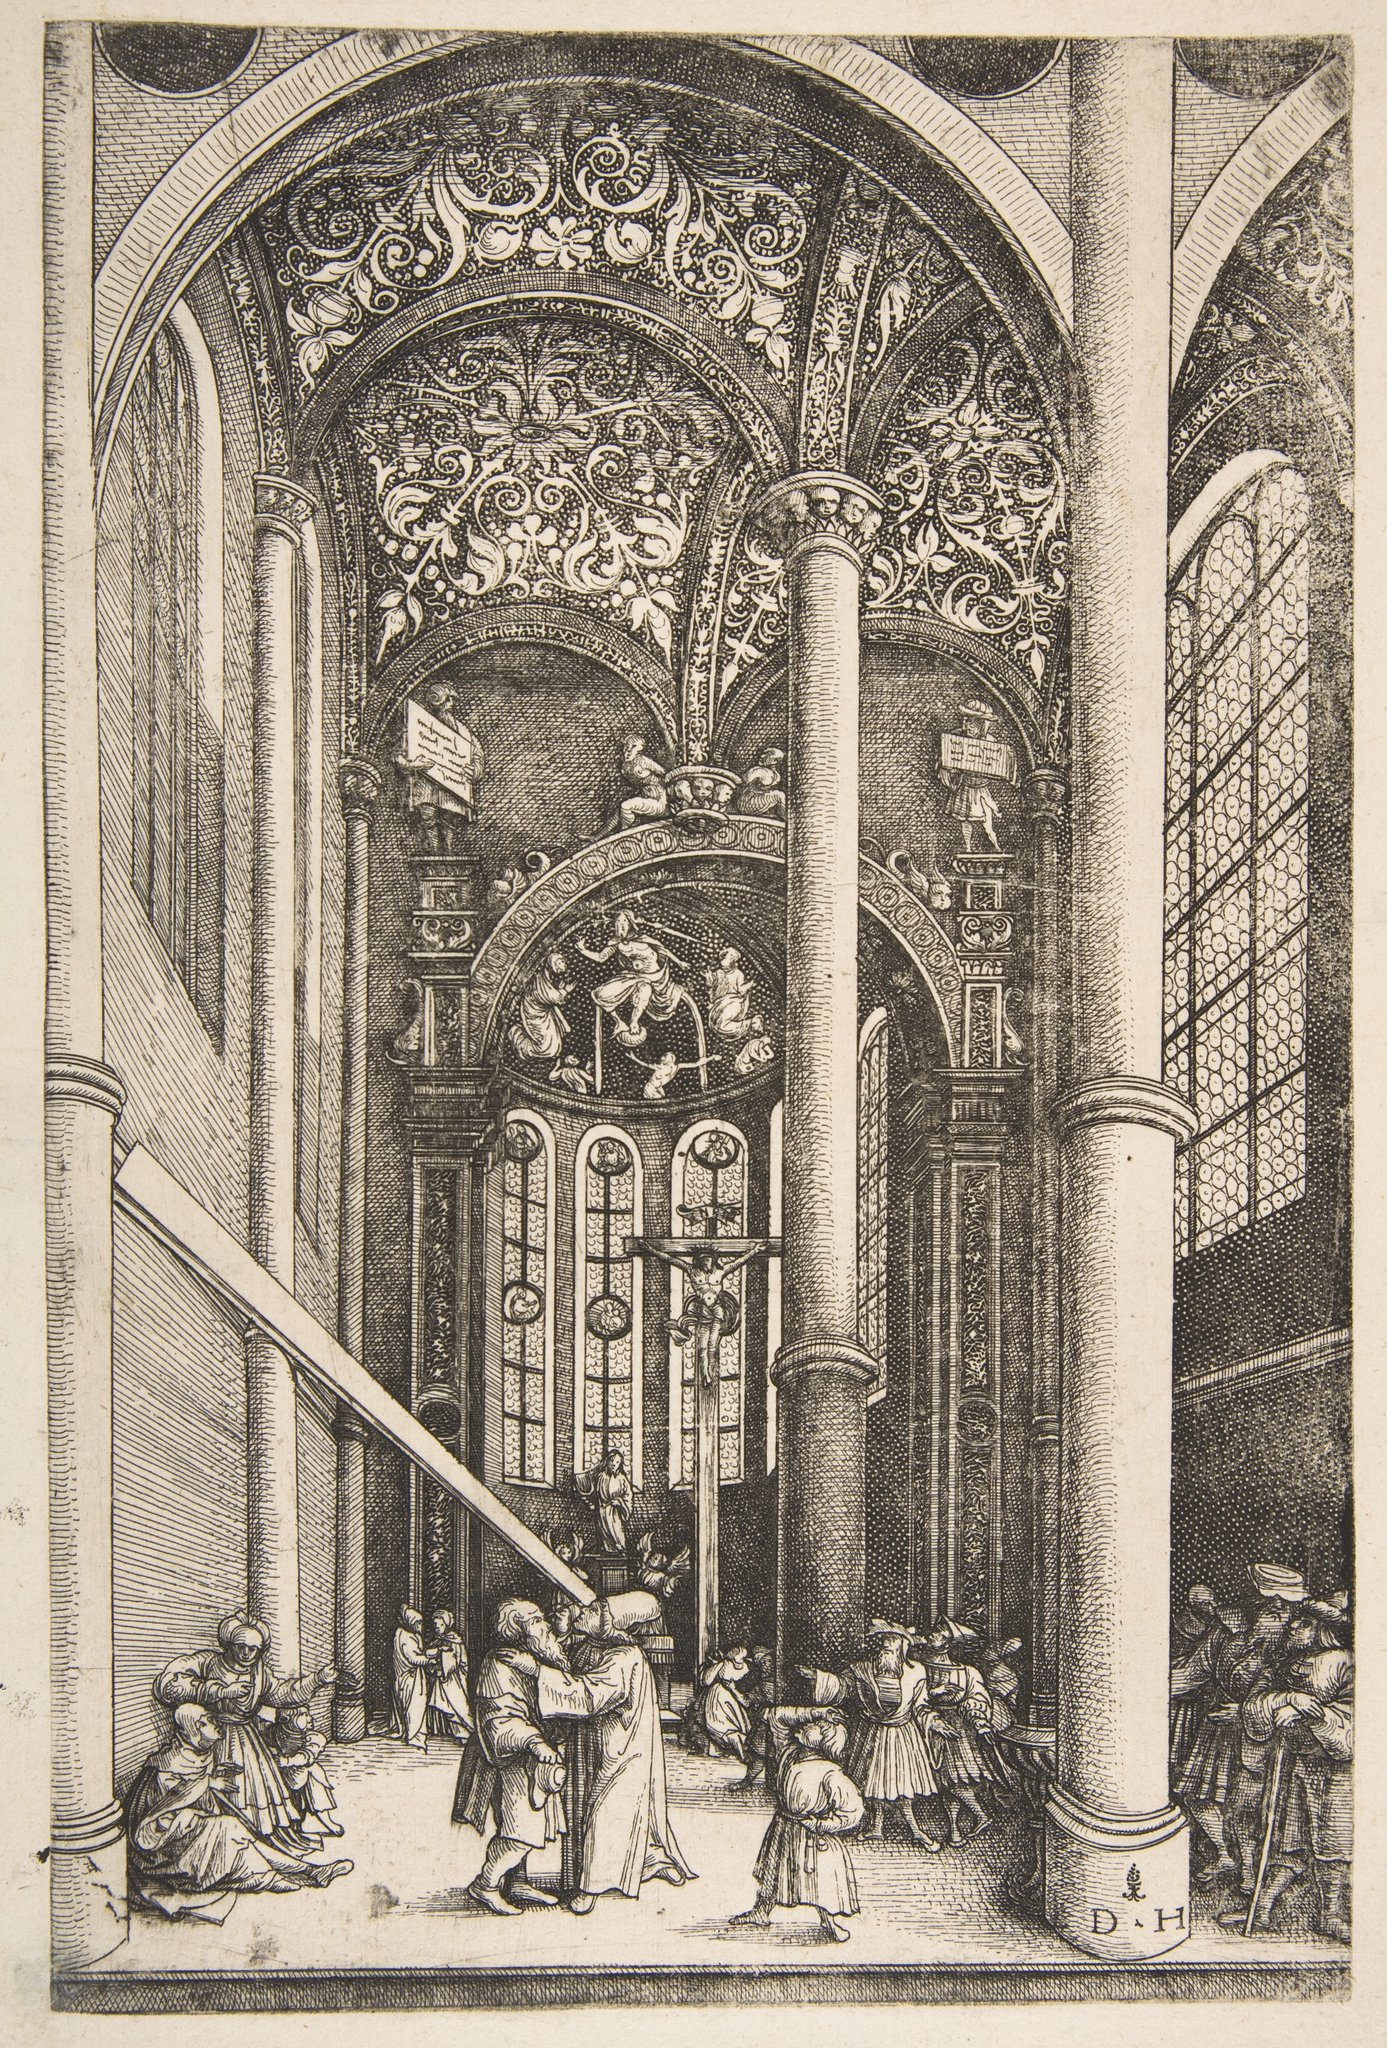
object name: print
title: Interior of the Church of Saint Katherine’s with the Parable of the Mote and the Beam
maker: daniel hopfer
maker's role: artist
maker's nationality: german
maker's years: 1470-1536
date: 1530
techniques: etching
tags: interiors,churches,parables